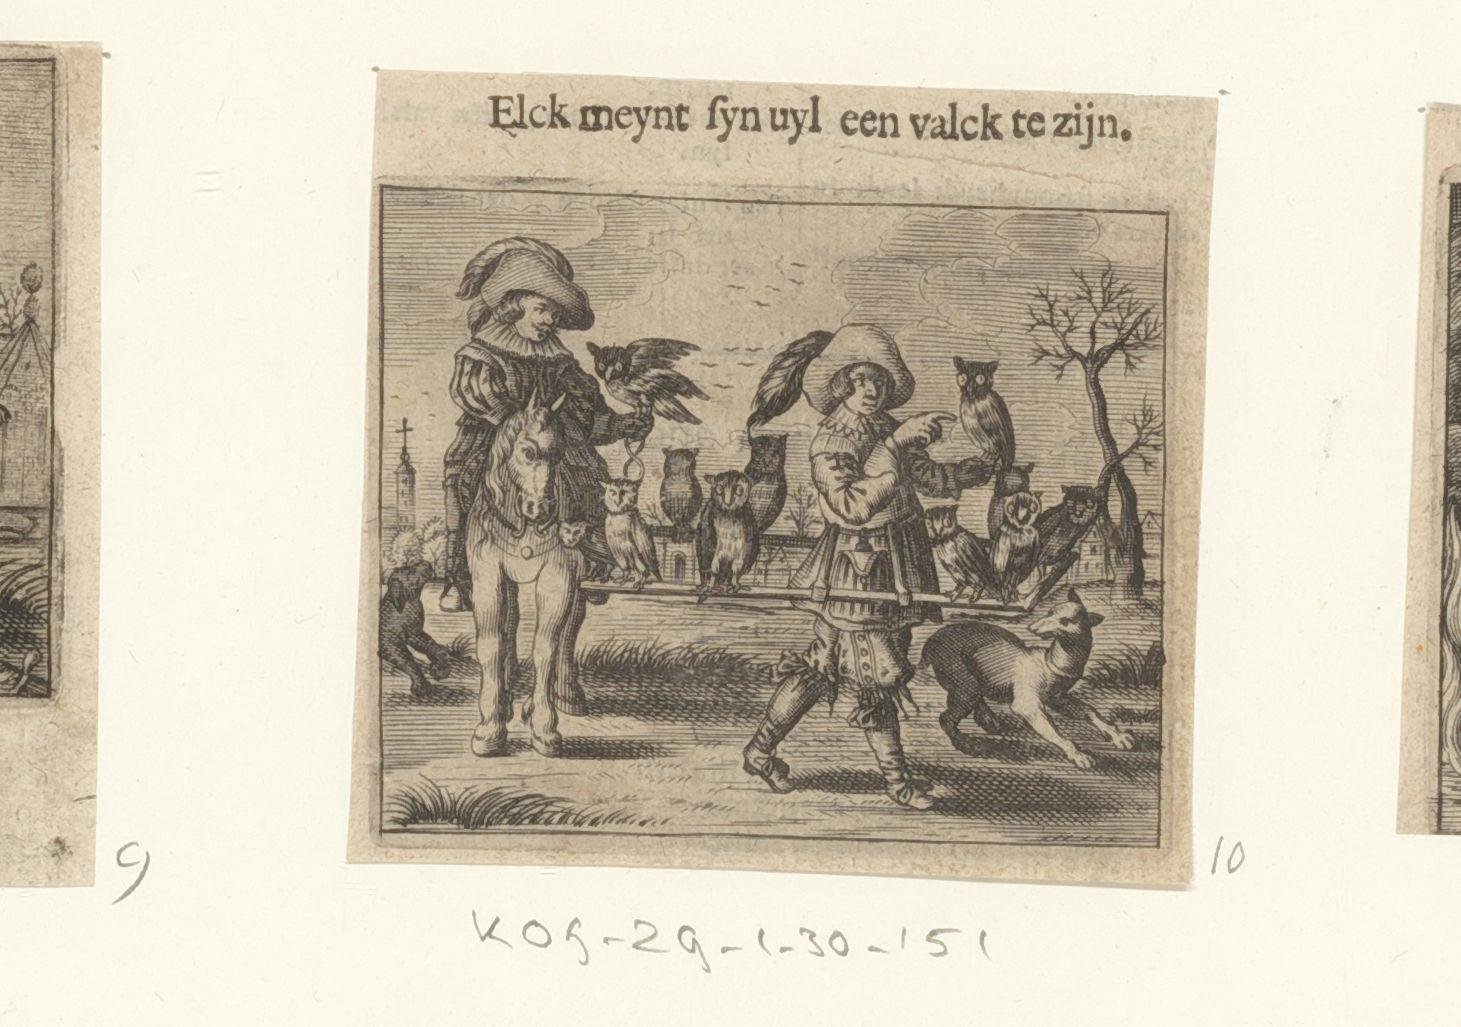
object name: print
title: Elck meynt syn uyl een valck te zijn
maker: Anonymous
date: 1635-1715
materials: paper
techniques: engraving, letterpress printing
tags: predatory birds: falcon, proverbs, sayings, etc., owls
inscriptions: stamp, collector's mark: Lugt 1641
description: Veel versies van dit embleem verschenen in verschillende uitgave van Spiegel van den Ouden ende Nieuwen Tydt. Zoals: Cats, Jacob. Spiegel van den Ouden ende Nieuwen-tijt, Bestaende uyt Spreeck-woorden (...). Dordrecht: Jacob Braat, 1647. Maar ook in andere publicaties (1665, 1671, 1715, 1722).